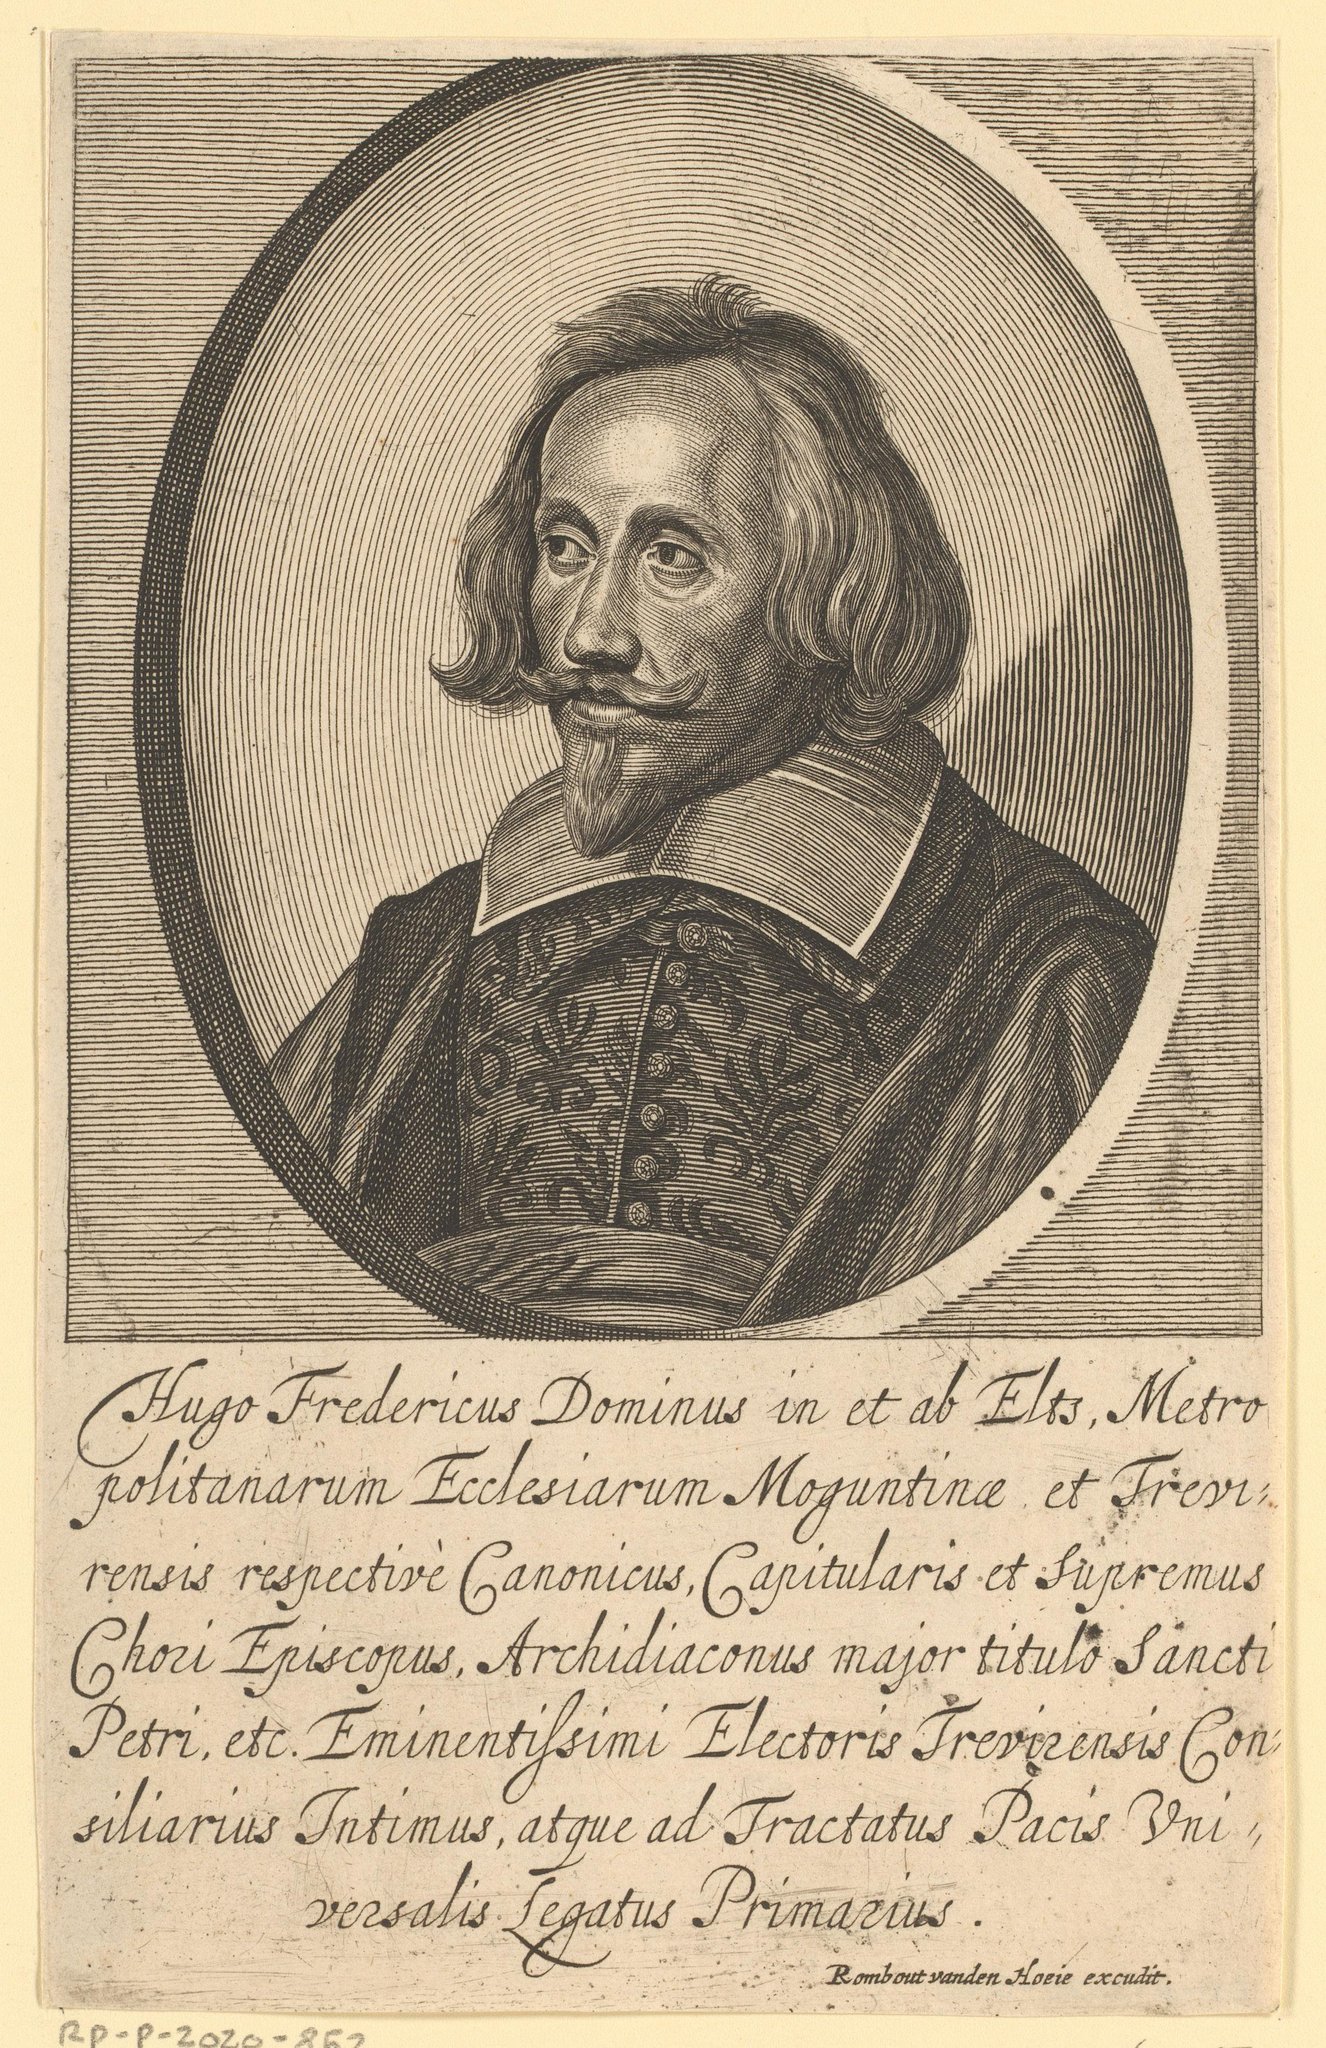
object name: print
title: Portretten van vredesonderhandelaars in Westfalen 1641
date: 1644-1671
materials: paper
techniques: engraving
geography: amsterdam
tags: official; civil servant; functionary (in general), historical persons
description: Prent maakt deel uit van een serie van 43 prenten. Eerdere staat van prent gebruikt in de serie 'Icones legatorum Monasterii et Osnabrugae existentium', uitgegeven door Abraham van Waesbergen in Amsterdam.